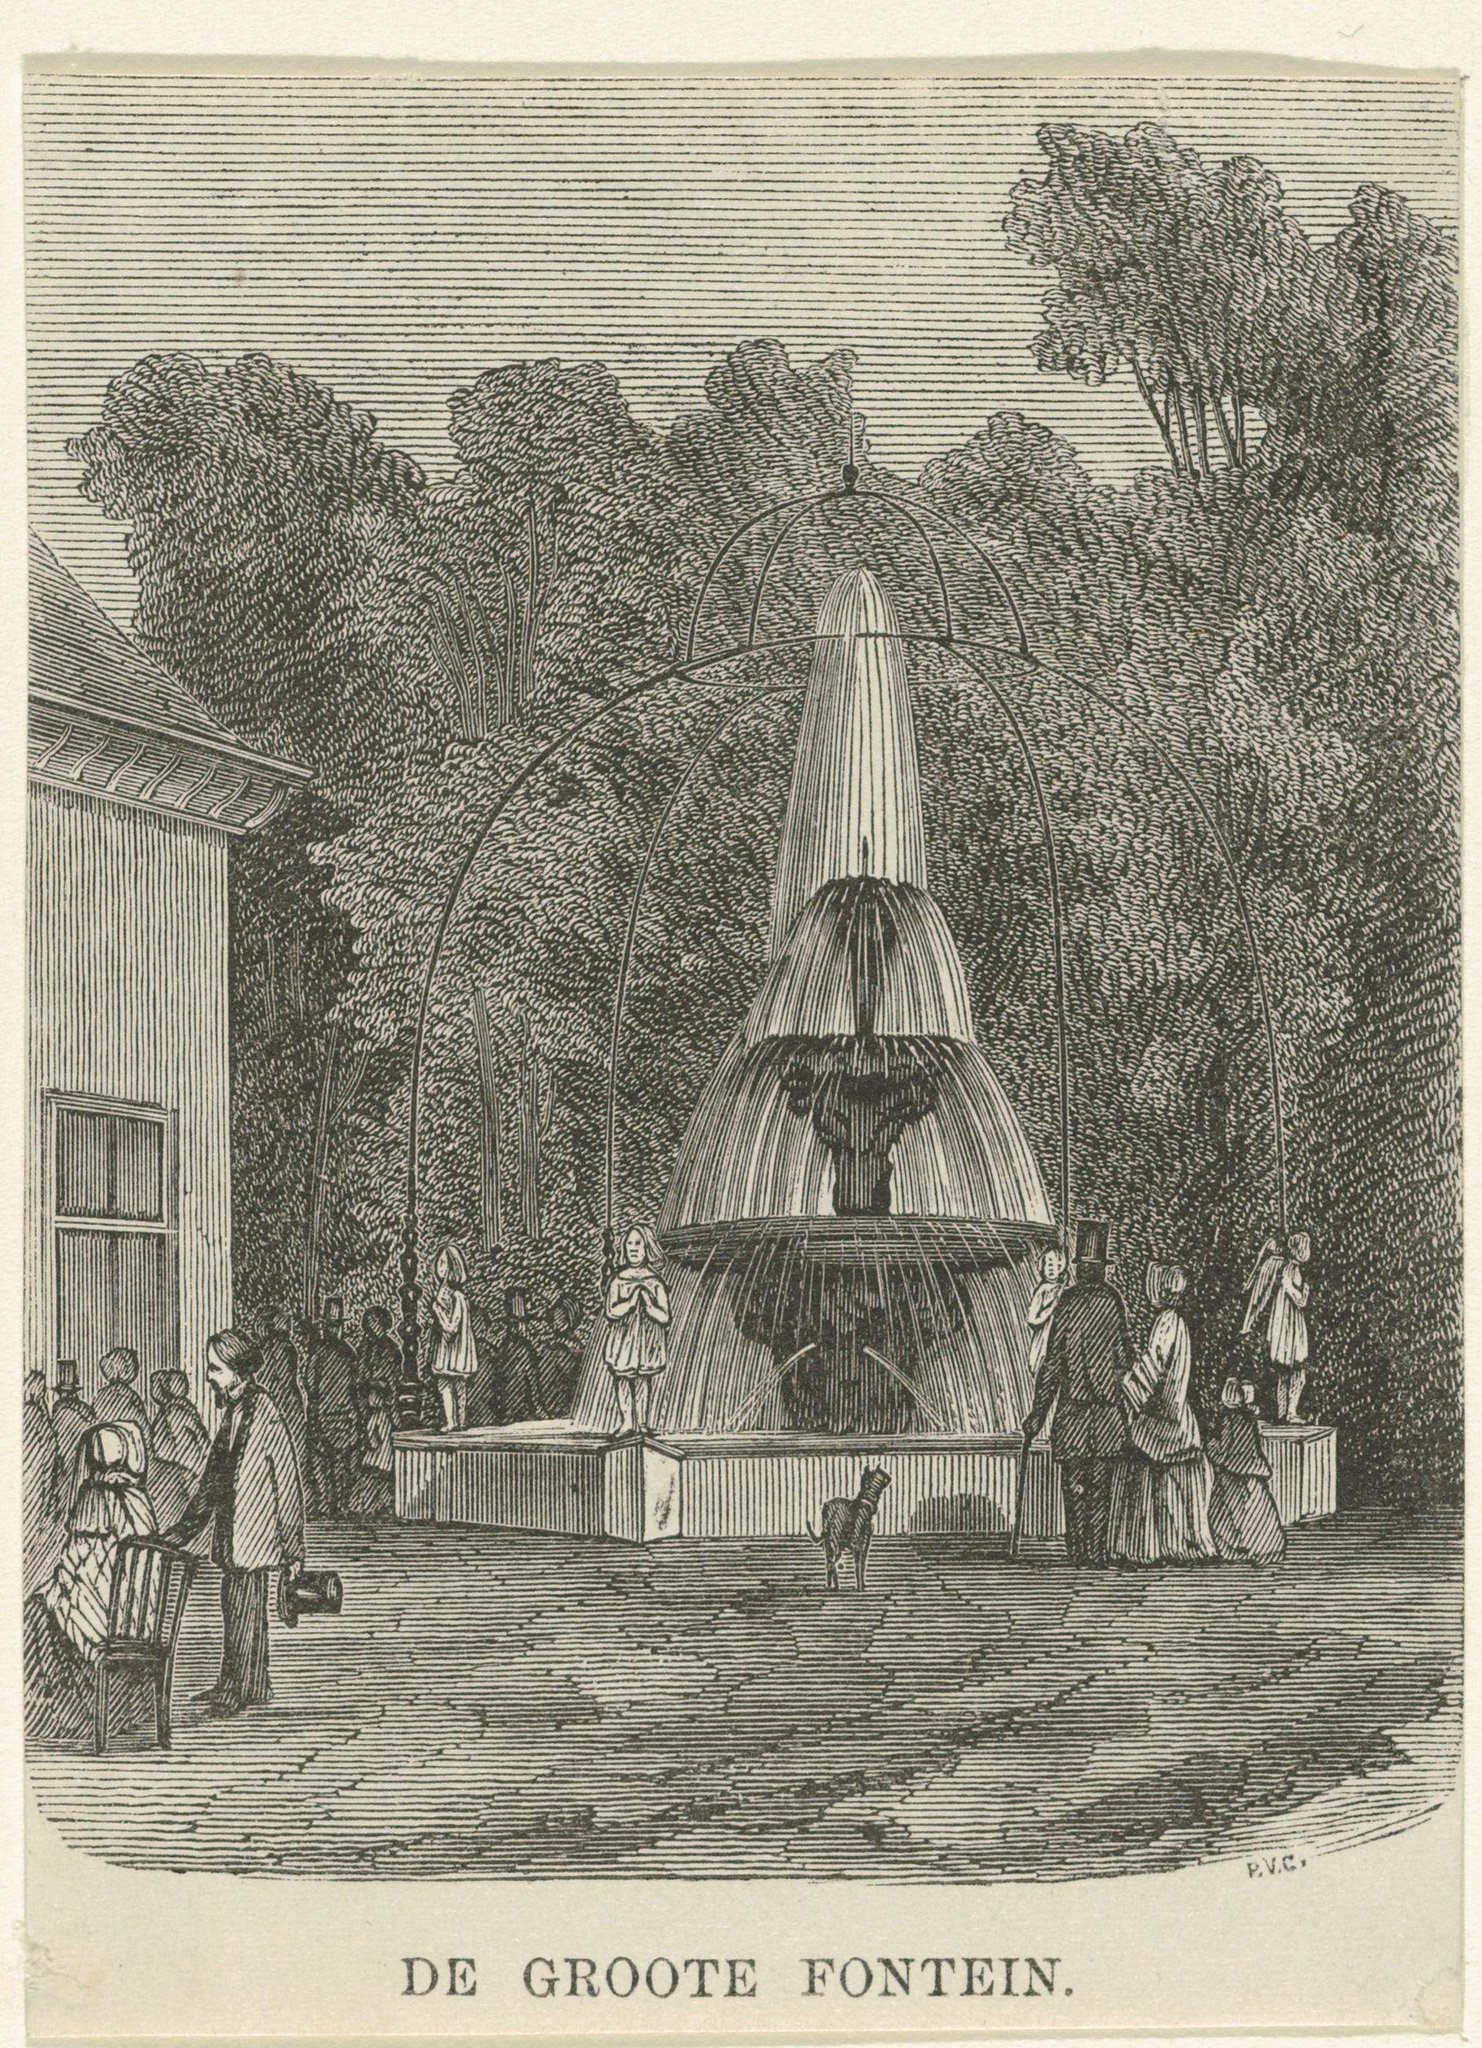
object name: print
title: De groote fontein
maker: popko van groningen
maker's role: print maker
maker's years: 1822-1888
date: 1832-1888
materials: paper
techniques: letterpress printing, engraving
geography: netherlands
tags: french or architectonic garden; formal garden